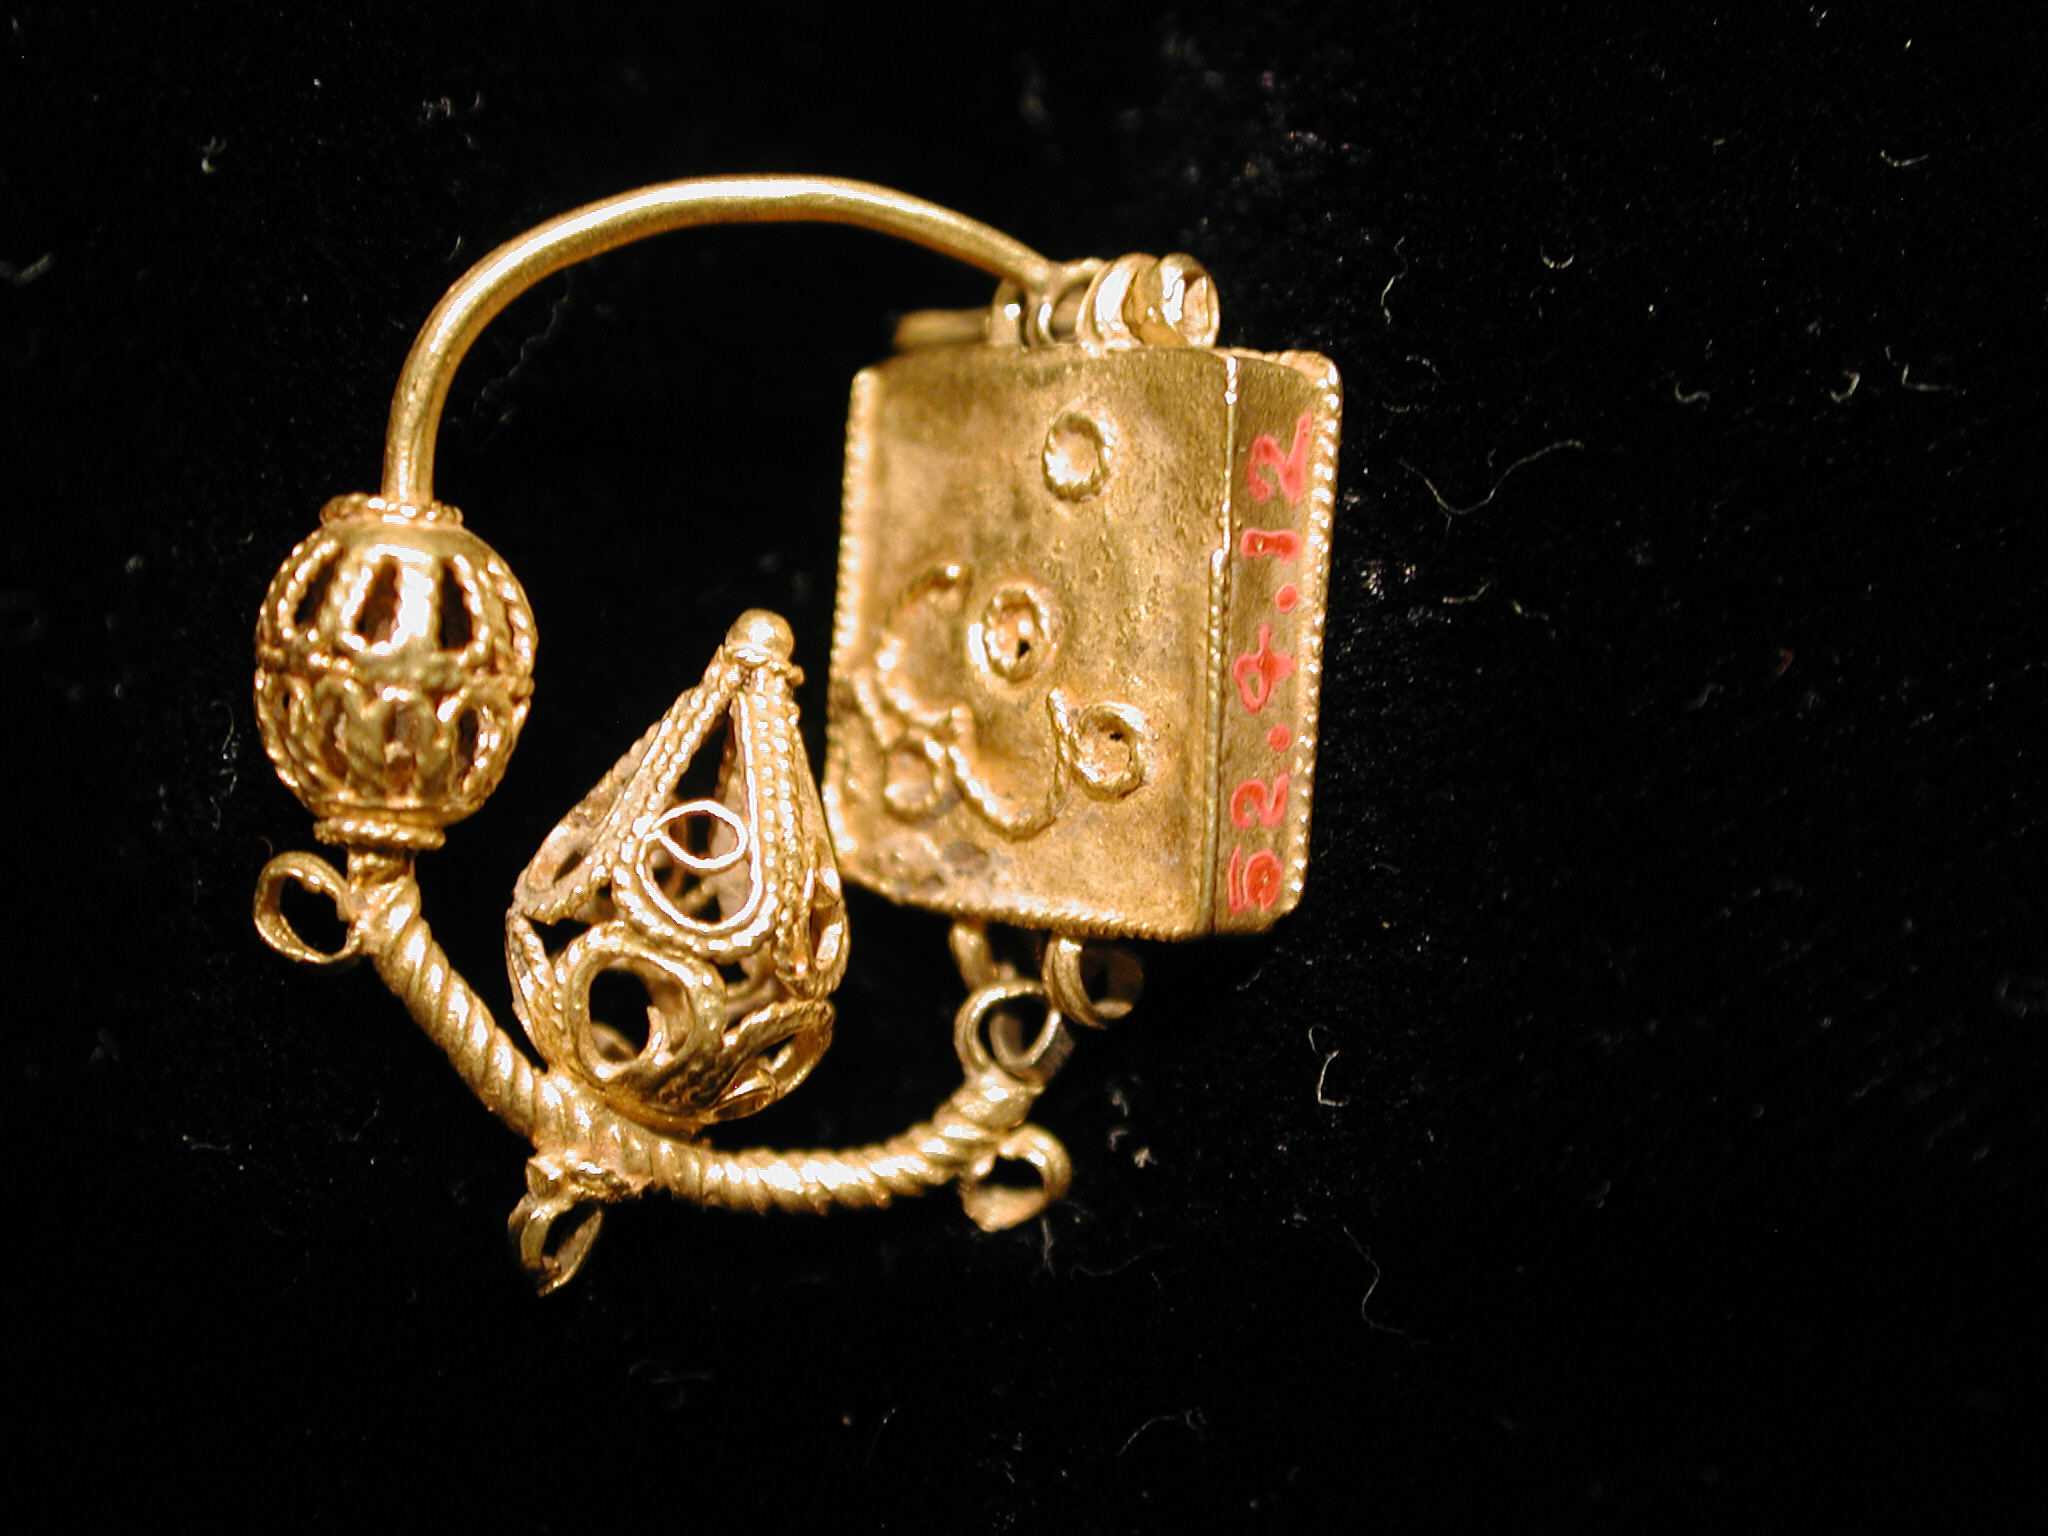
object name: earring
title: Earring, One of a Pair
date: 1001-1200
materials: gold, metal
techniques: filigree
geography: iran